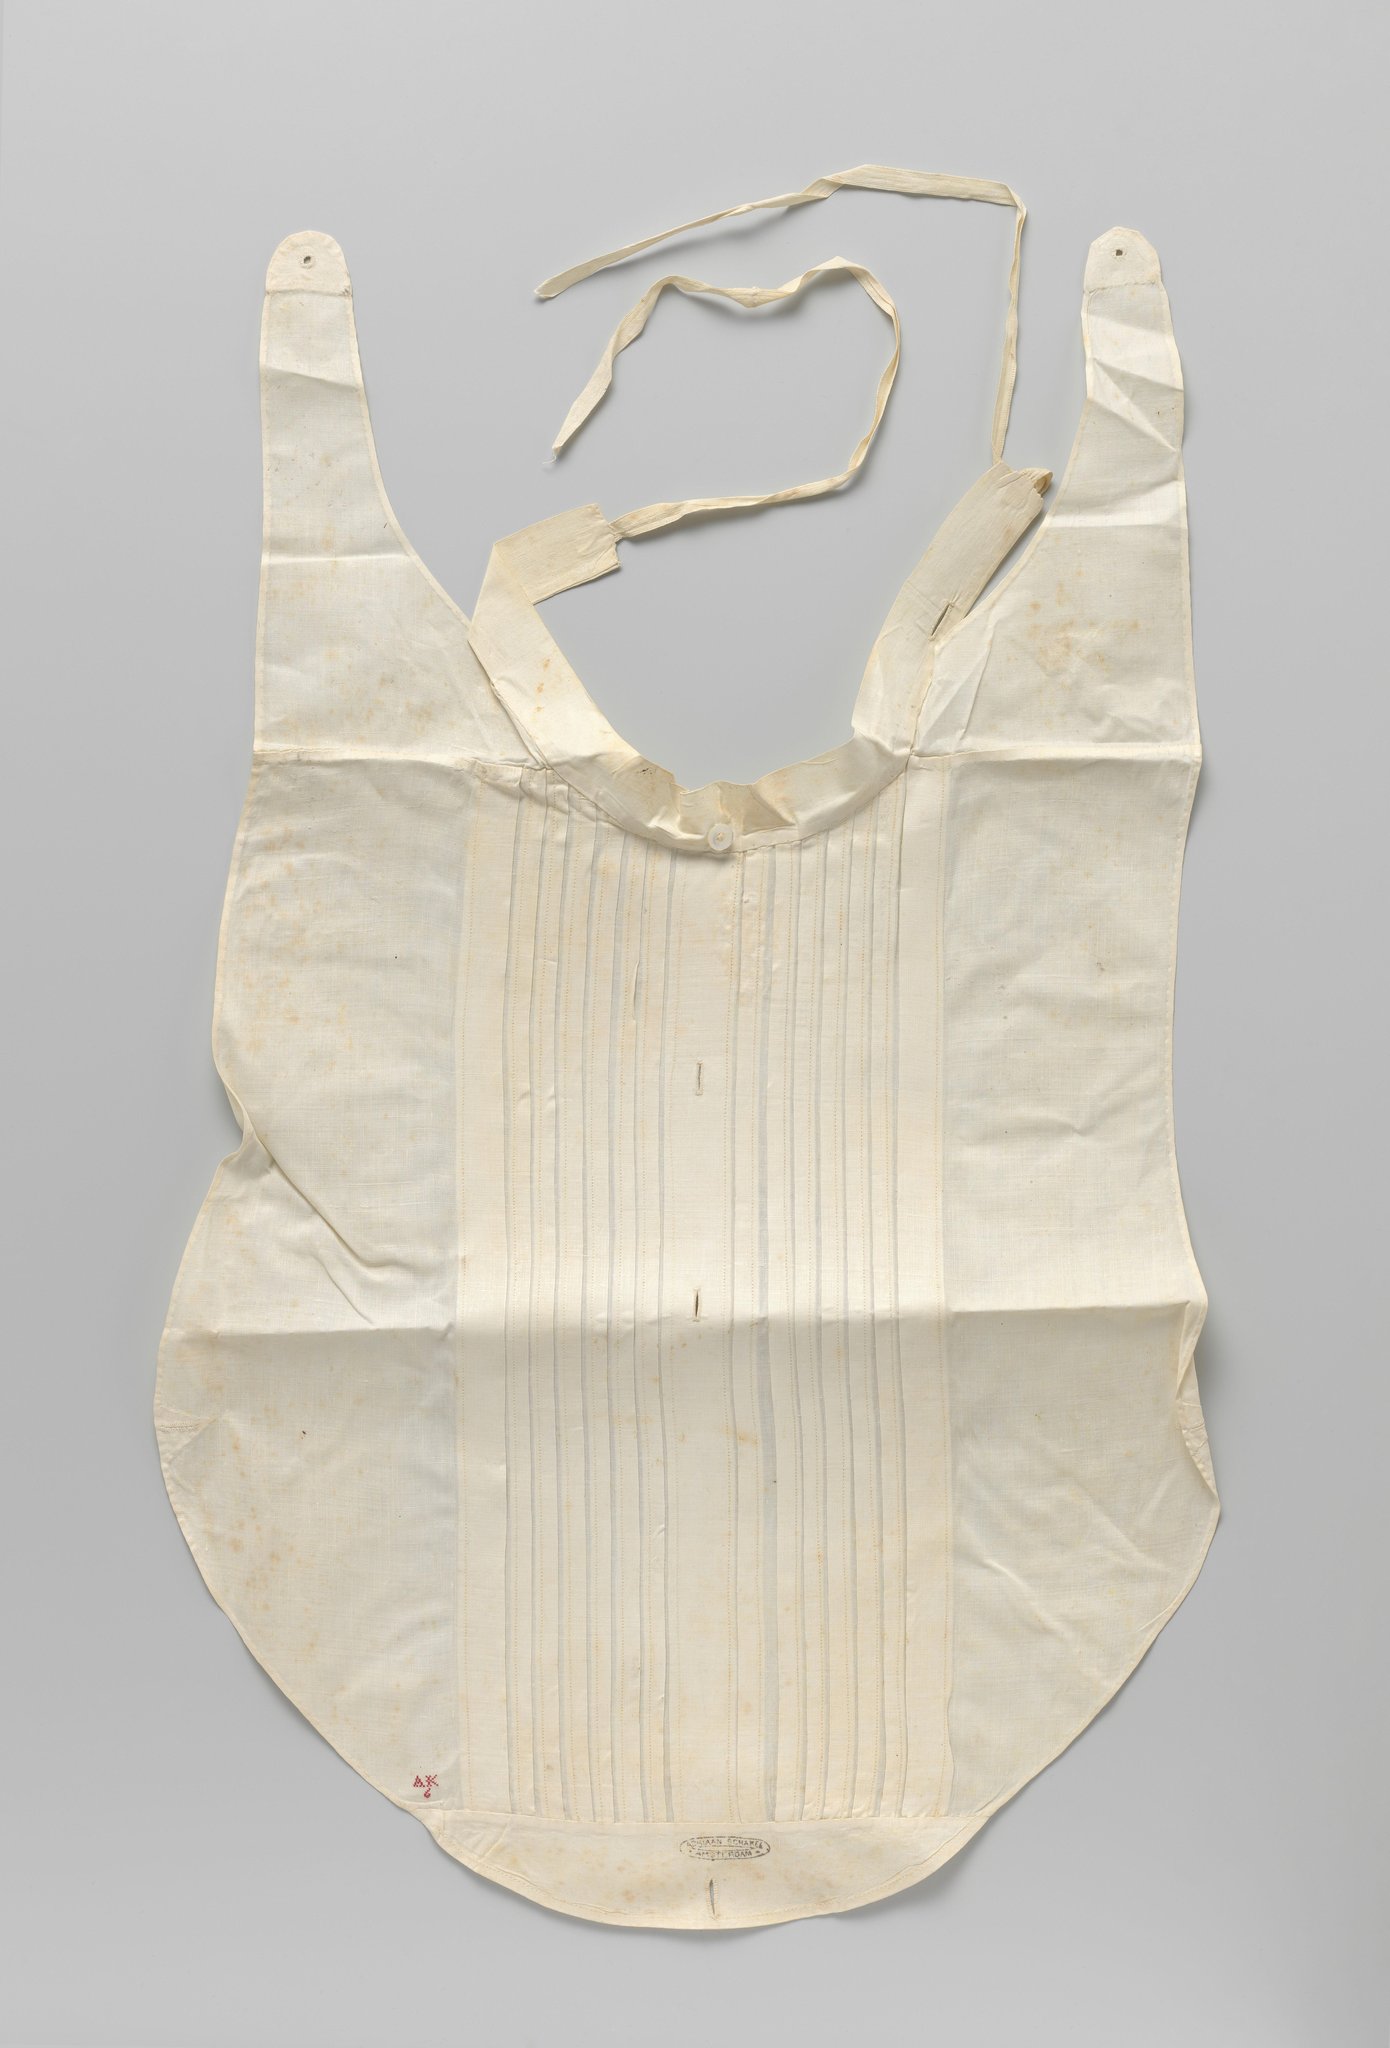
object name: band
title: Bef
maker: Anonymous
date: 1850-1920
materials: cotton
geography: europe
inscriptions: stamp: ‘ADRIAAN SCHAKEL / AMSTERDAM’, initials: ‘AK / 6’